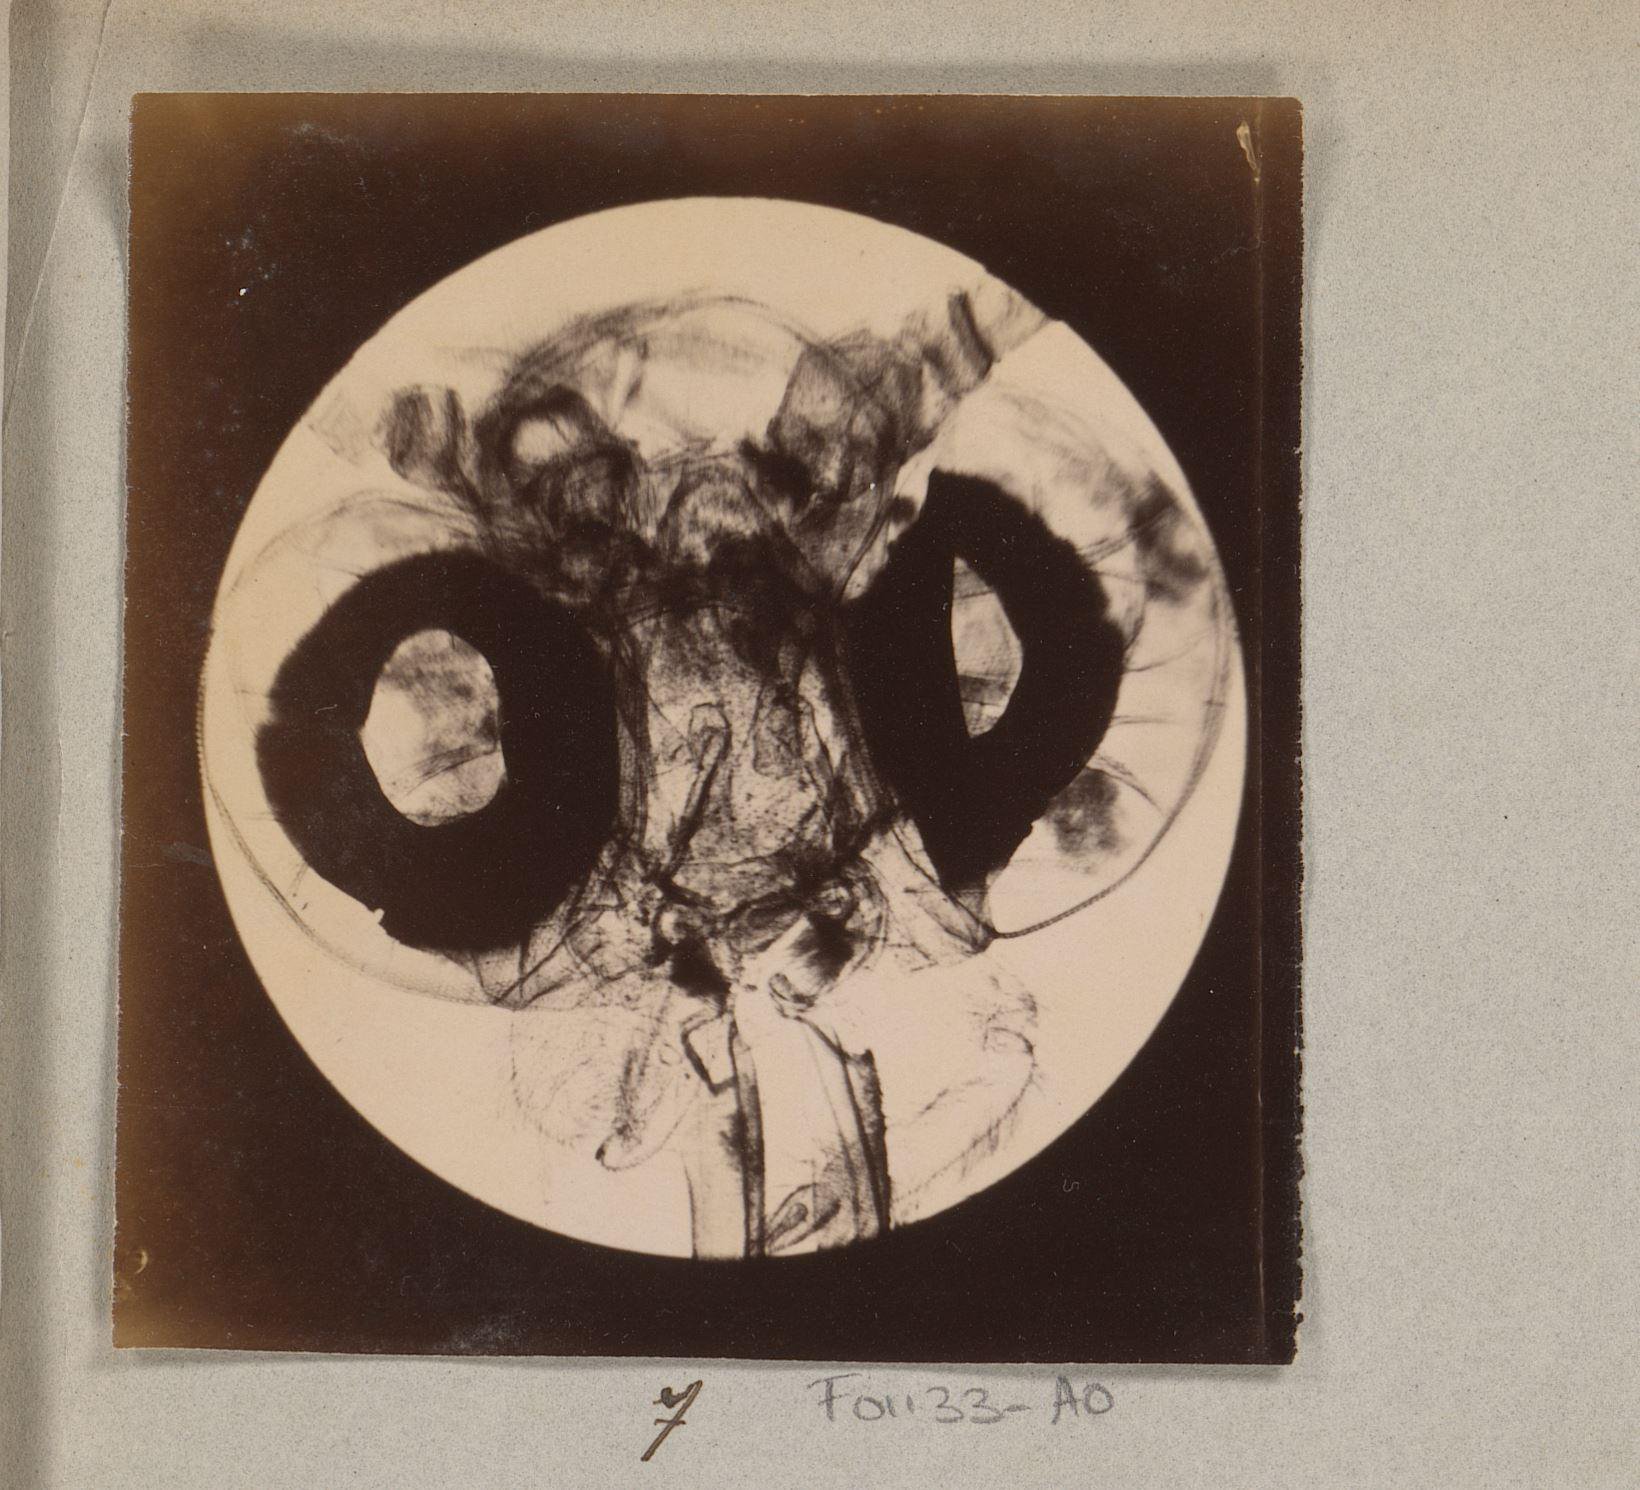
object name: photograph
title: Microscopische opname van kop van een nachtvlinder, negentig keer vergroot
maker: marinus pieter filbri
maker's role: instrument maker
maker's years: 1852-1917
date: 1887-1888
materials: paper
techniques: albumen print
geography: netherlands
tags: insects: moth, netherlands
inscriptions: number: ‘7’, inscription: ‘No. 7. Benaming Kop van een nachtvlinder, 90 x vergroot, pose 5 min., bemerking Monckhoven’